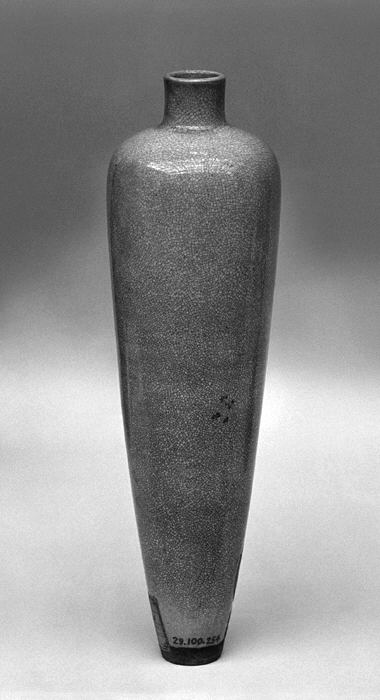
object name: vase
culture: chinese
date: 1368-1644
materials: glaze, porcelain